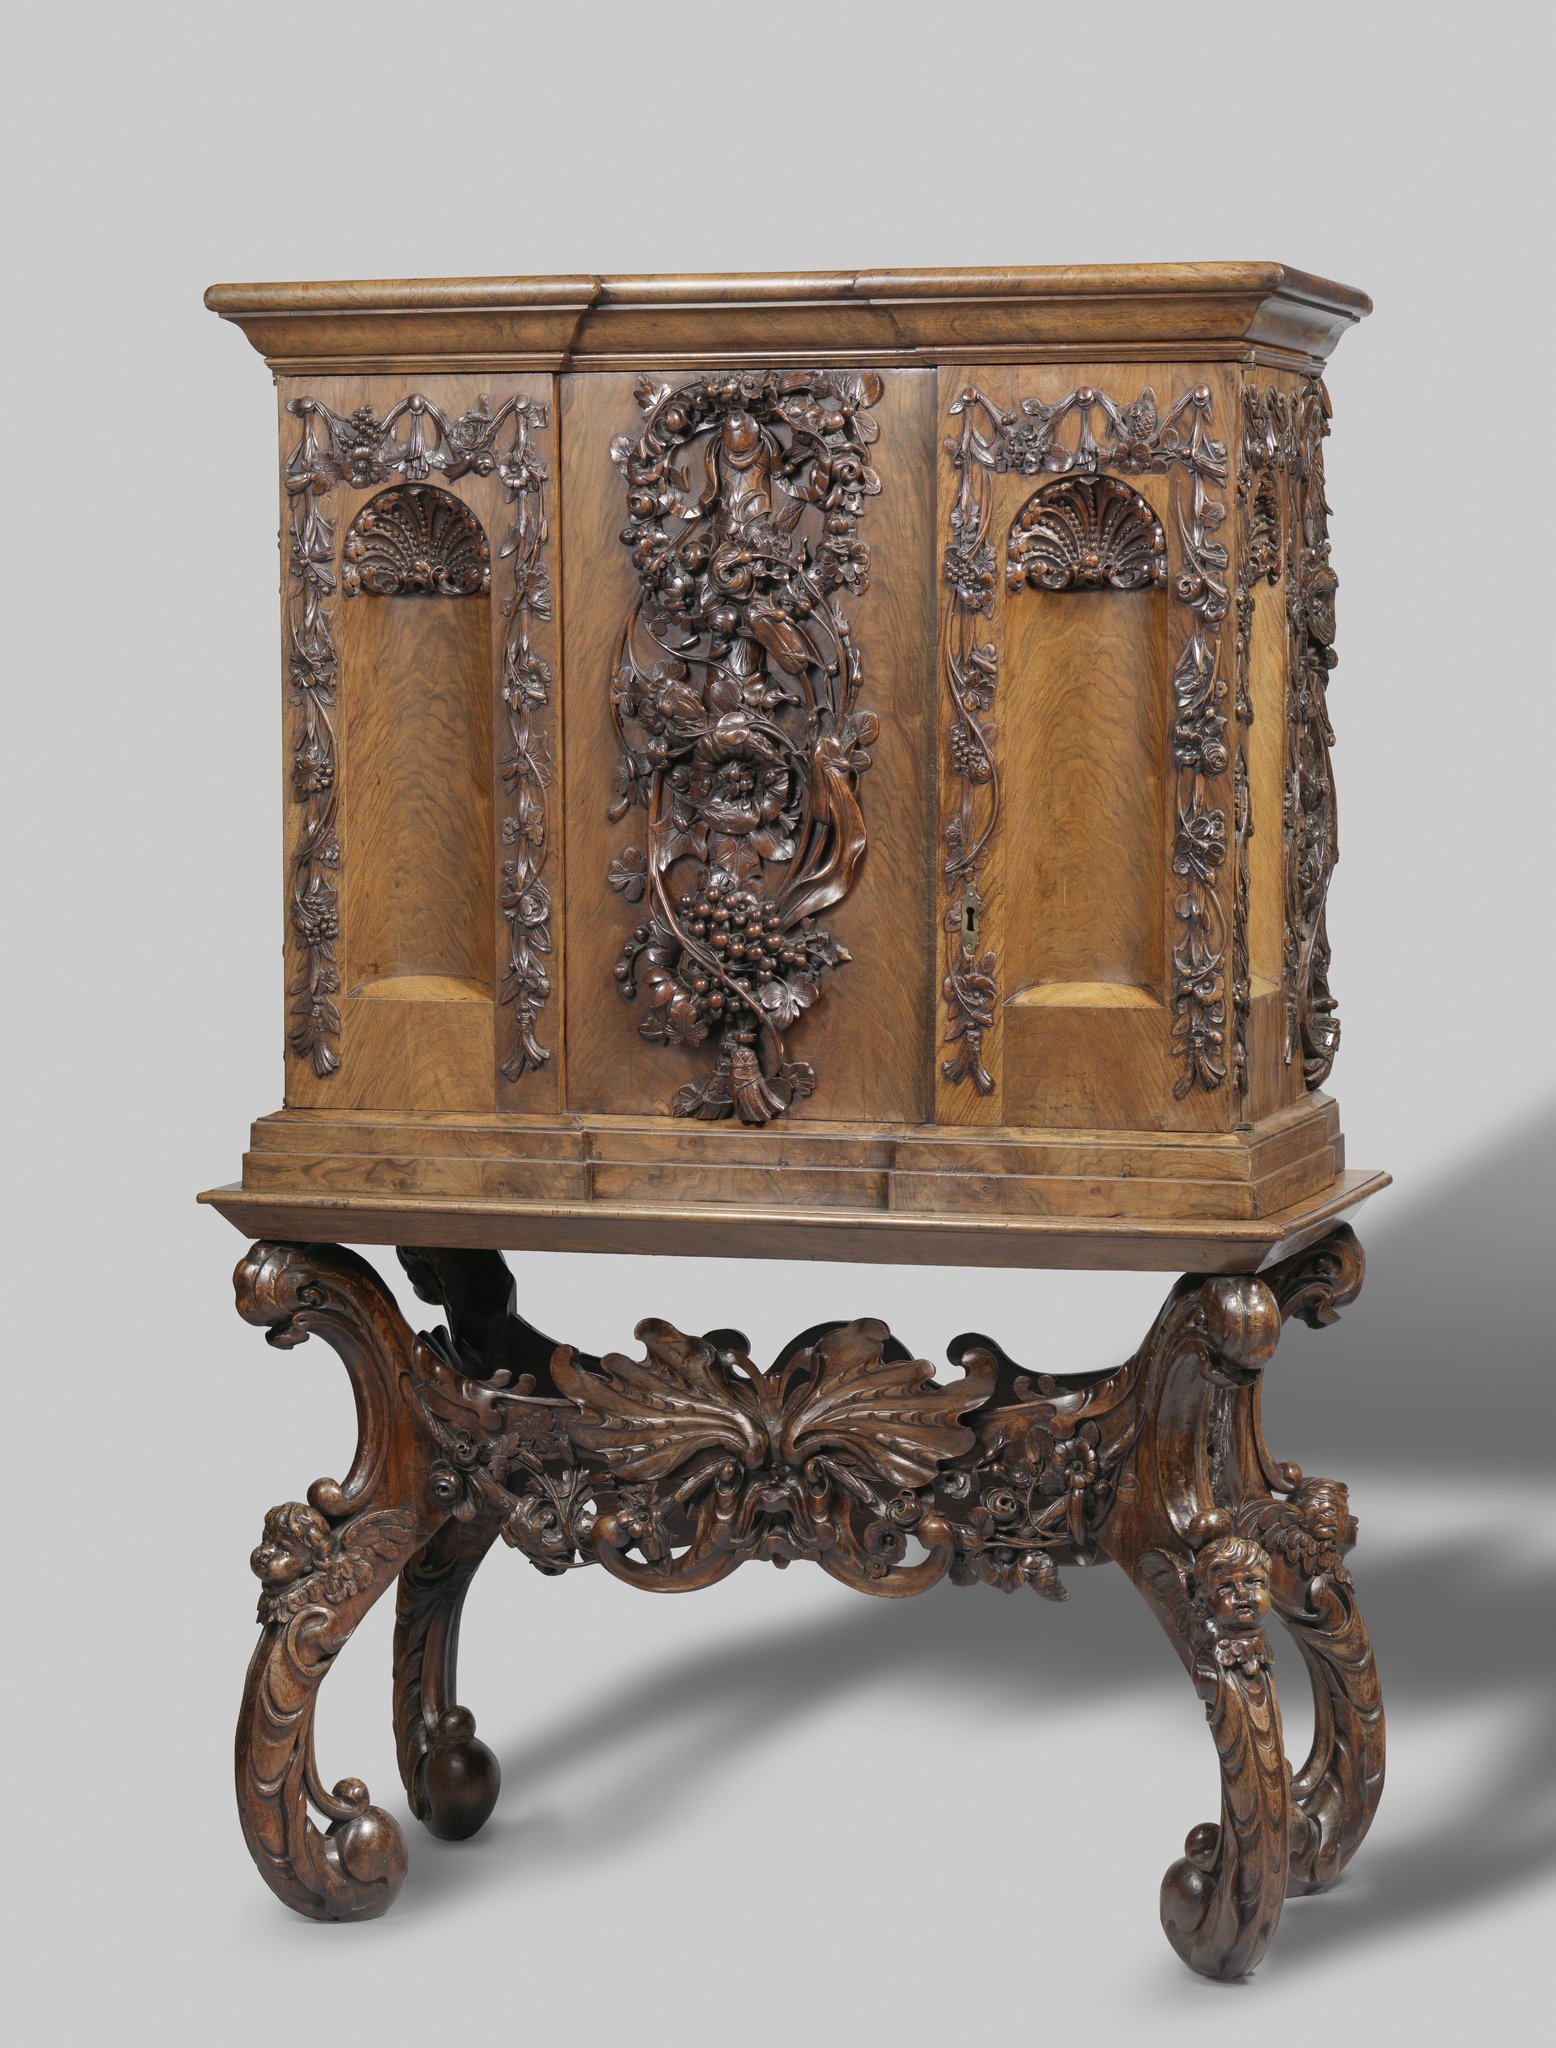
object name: case furniture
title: Layette Cupboard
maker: Anonymous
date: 1660-1670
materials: wood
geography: amsterdam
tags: cherubs, i.e. children's heads with wings, auricular ornament, lobe style ~ ornament, fruits and vegetables ~ ornament, ornament ~ festoon, garland, foliage, tendrils, branches ~ ornament, flowers ~ ornament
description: This cupboard was almost certainly made in the same workshop as the other example in this gallery. It features the same contrast between the rectangular cabinet and its auricular stand. In this case the kwab motifs are combined with naturalistic elements: angel’s heads and swags of flowers. This example was probably made a little later than the other one.